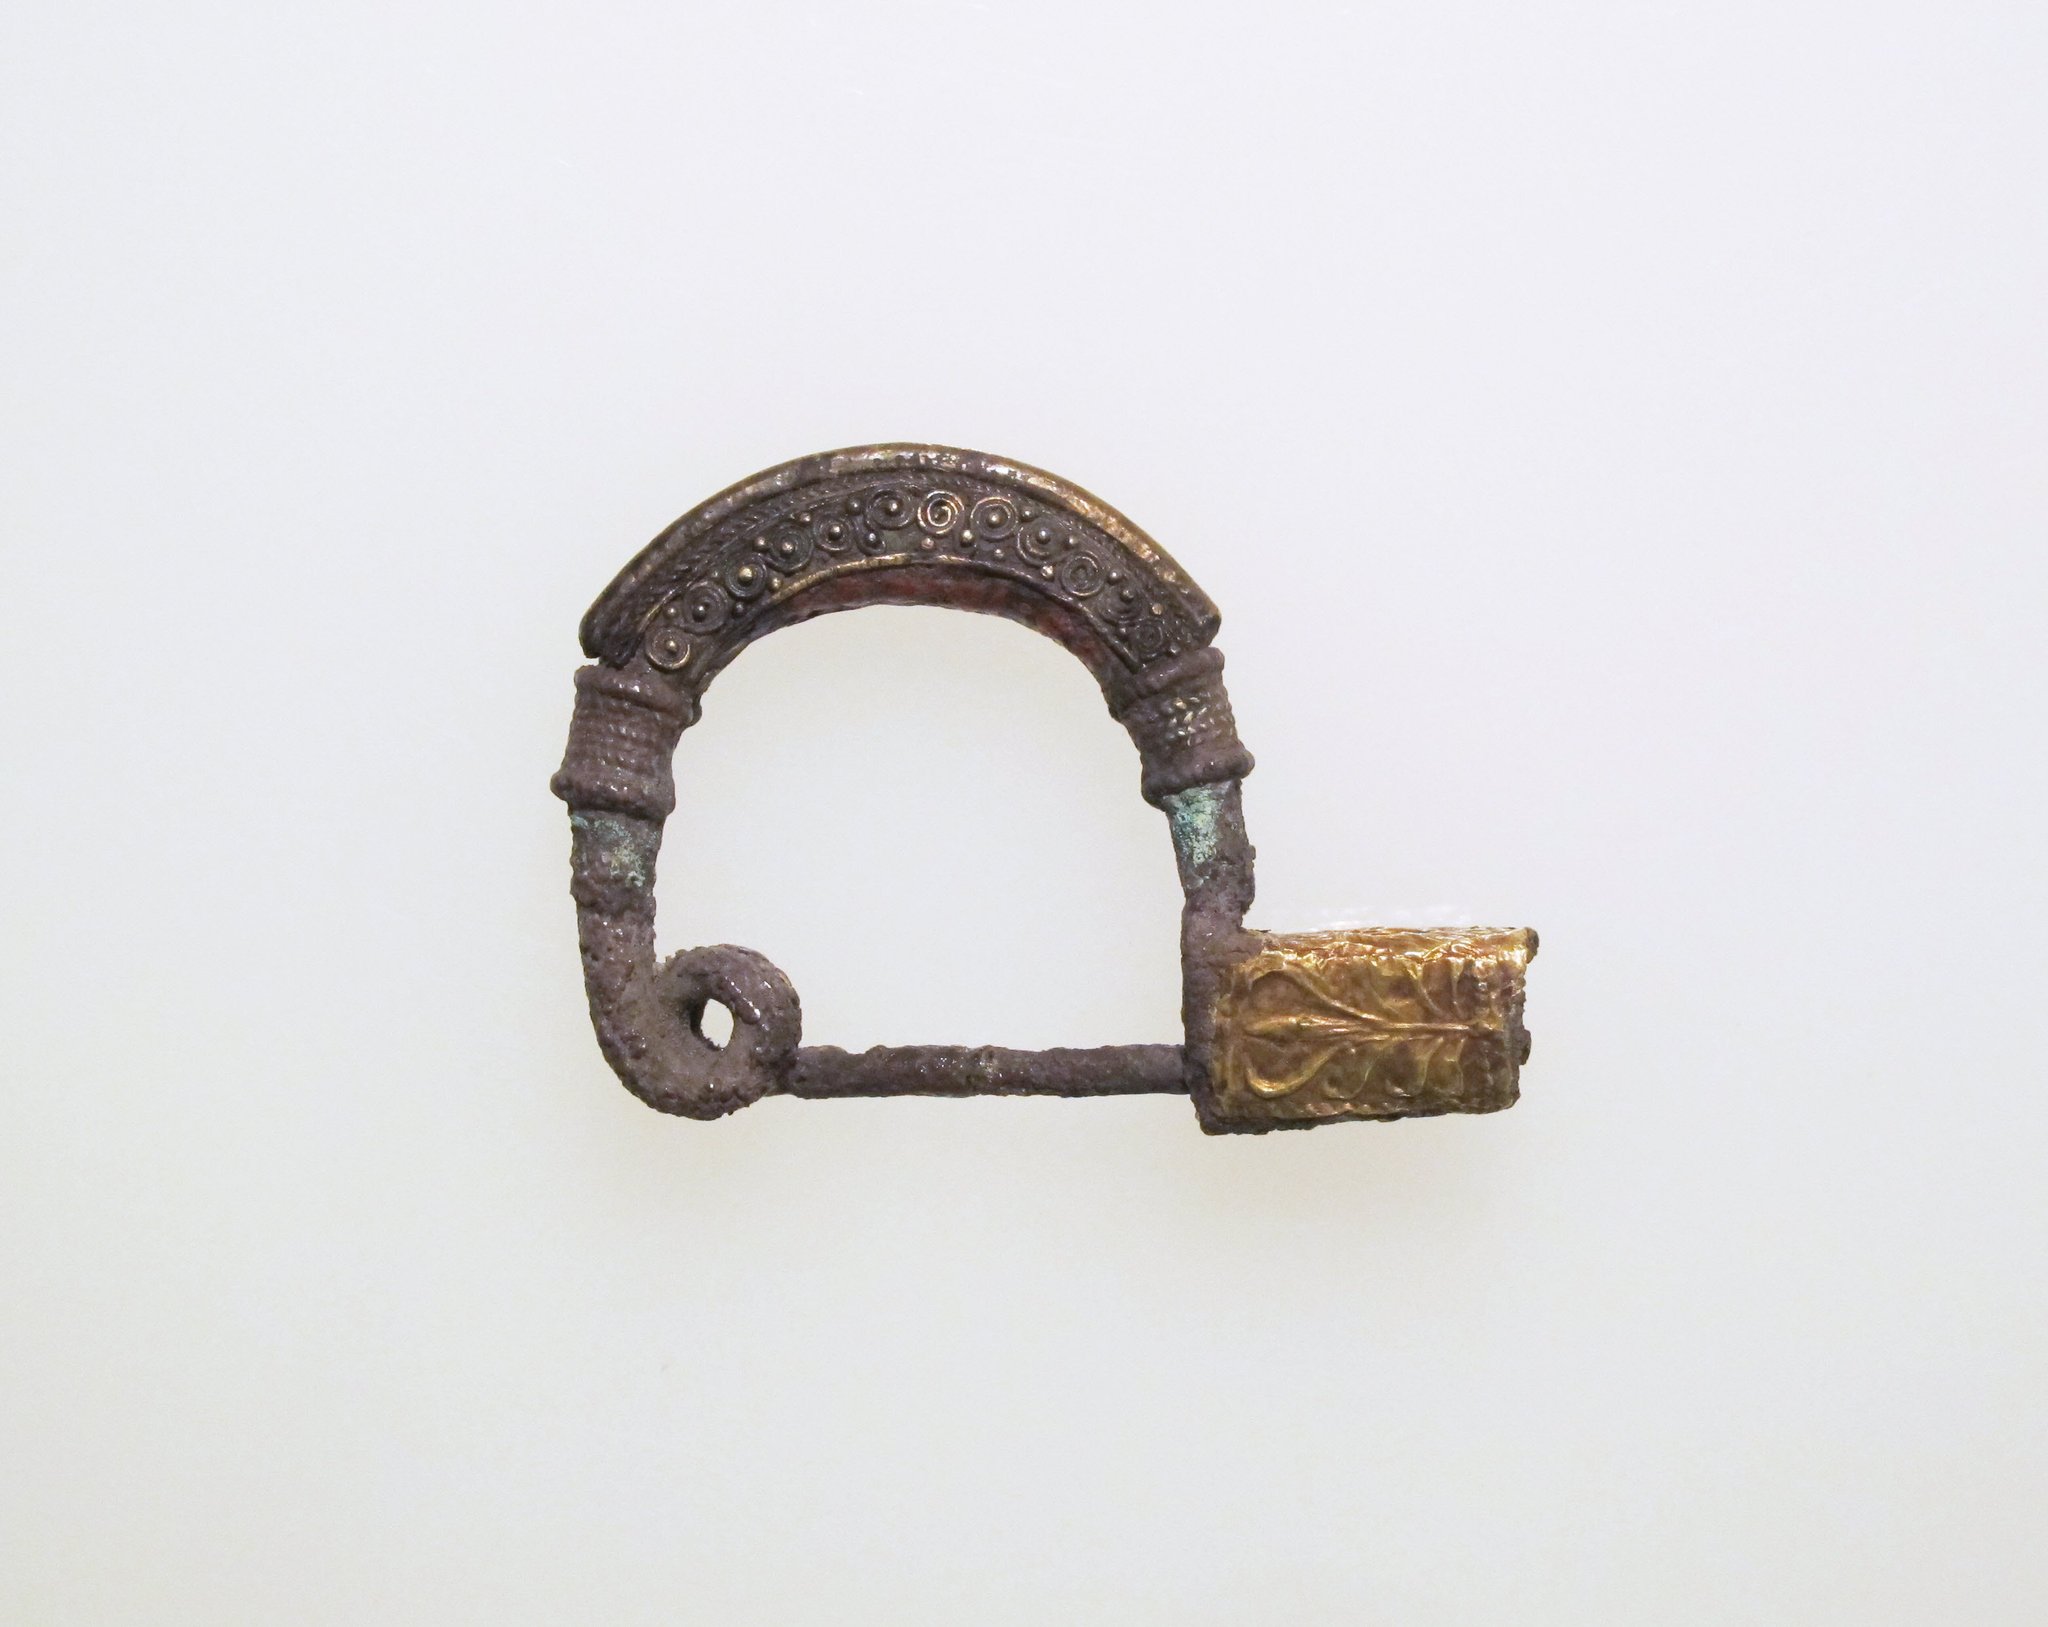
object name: fibula, bow shaped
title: Fibula, bow-shaped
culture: etruscan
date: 700-501 BCE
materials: silver